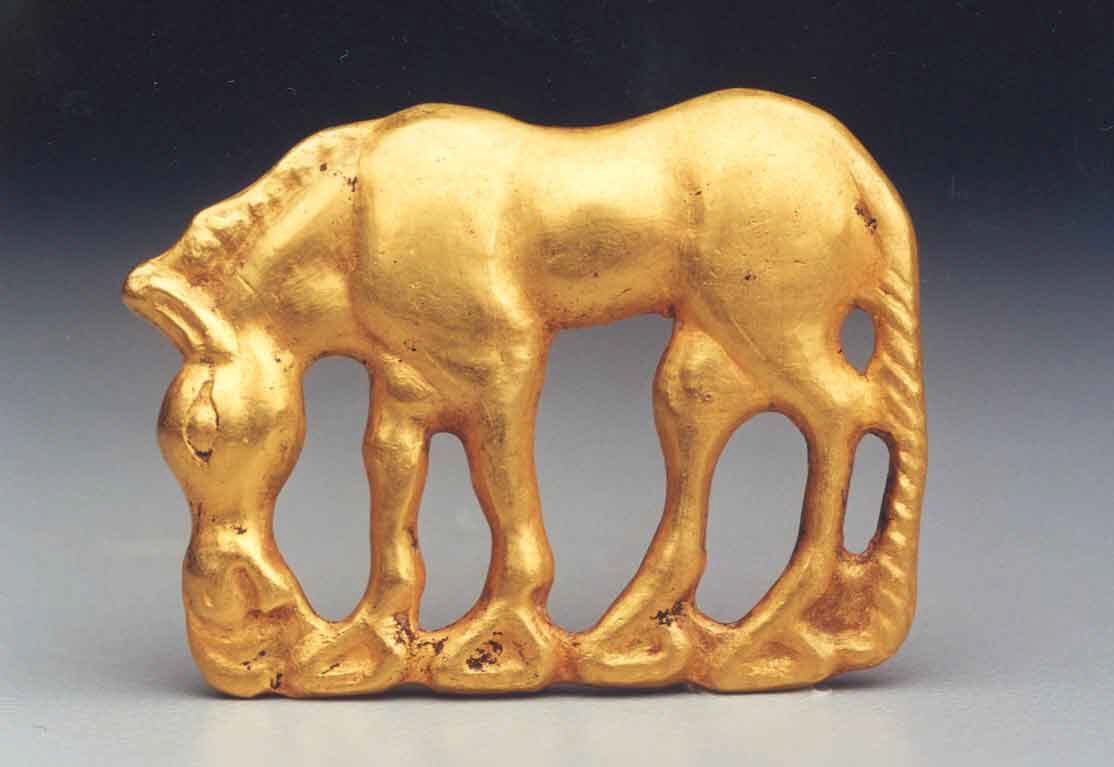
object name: plaque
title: Plaque in the Shape of a Grazing Kulan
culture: northwest chinese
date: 200-1 BCE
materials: gold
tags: animals